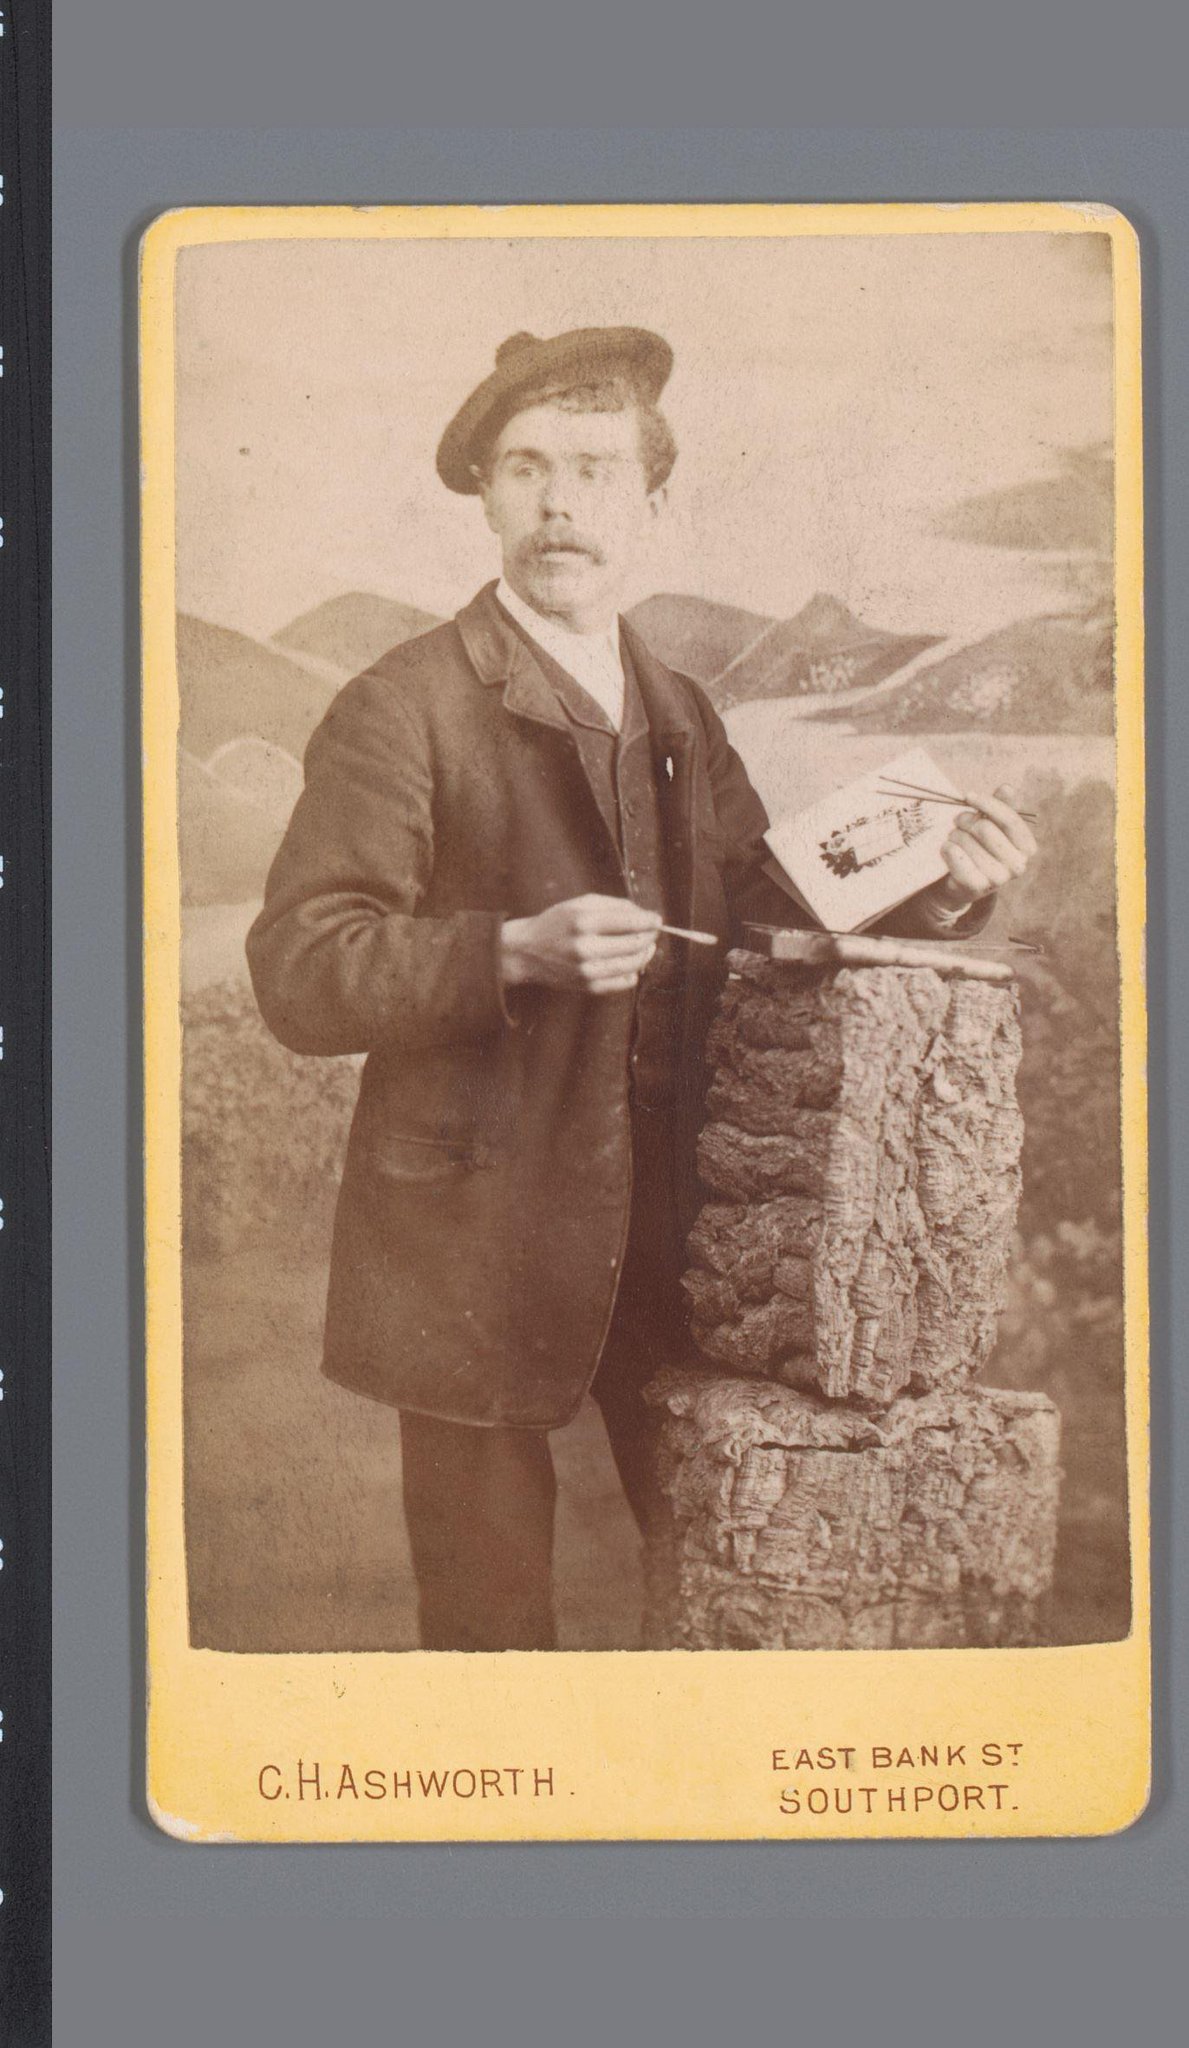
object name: carte de visite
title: Portret van een onbekende man als schilder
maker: c.h. ashworth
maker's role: fotograaf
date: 1855-1885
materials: cardboard, paper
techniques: albumen print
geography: southport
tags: portrait, self-portrait of painter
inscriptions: inscription: ‘Corner of Talbot &/ East Bank Street/ Southport/ Negatives kept Copies or/ Enlargements may always be Had’